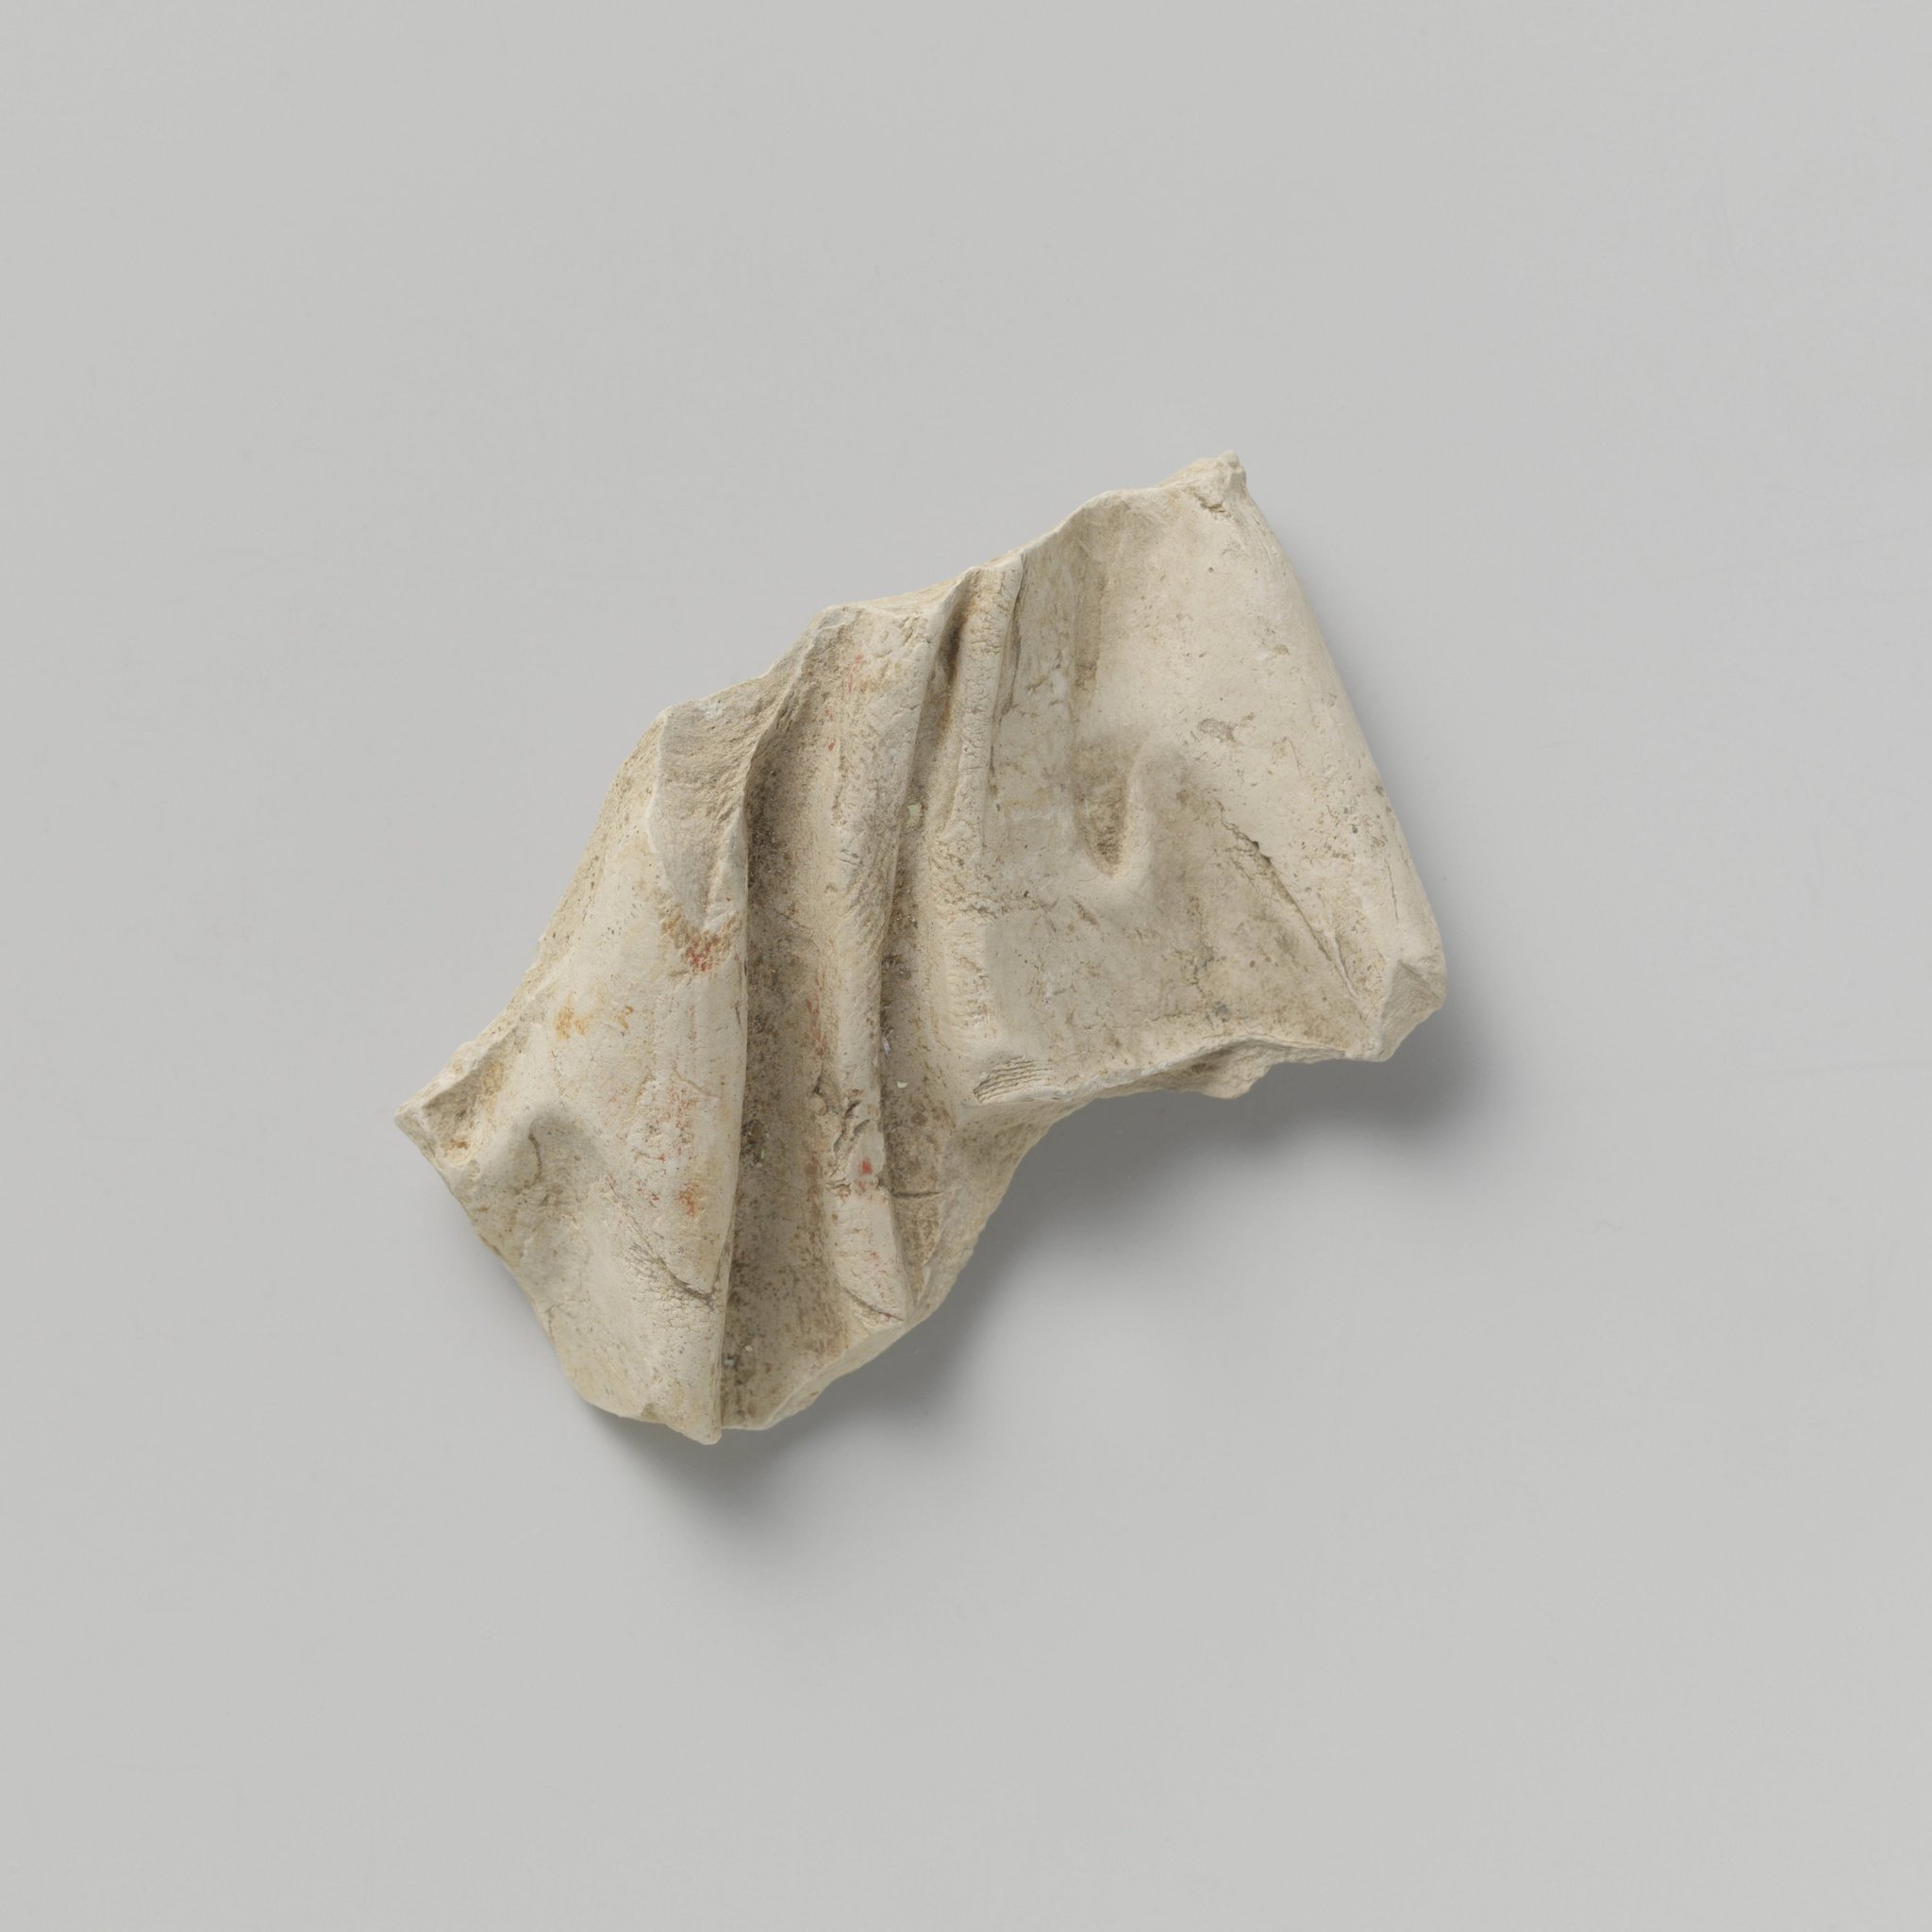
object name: sculpture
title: Figurine, Fragment of the Garment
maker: Anonymous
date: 1425-1550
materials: clay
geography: utrecht